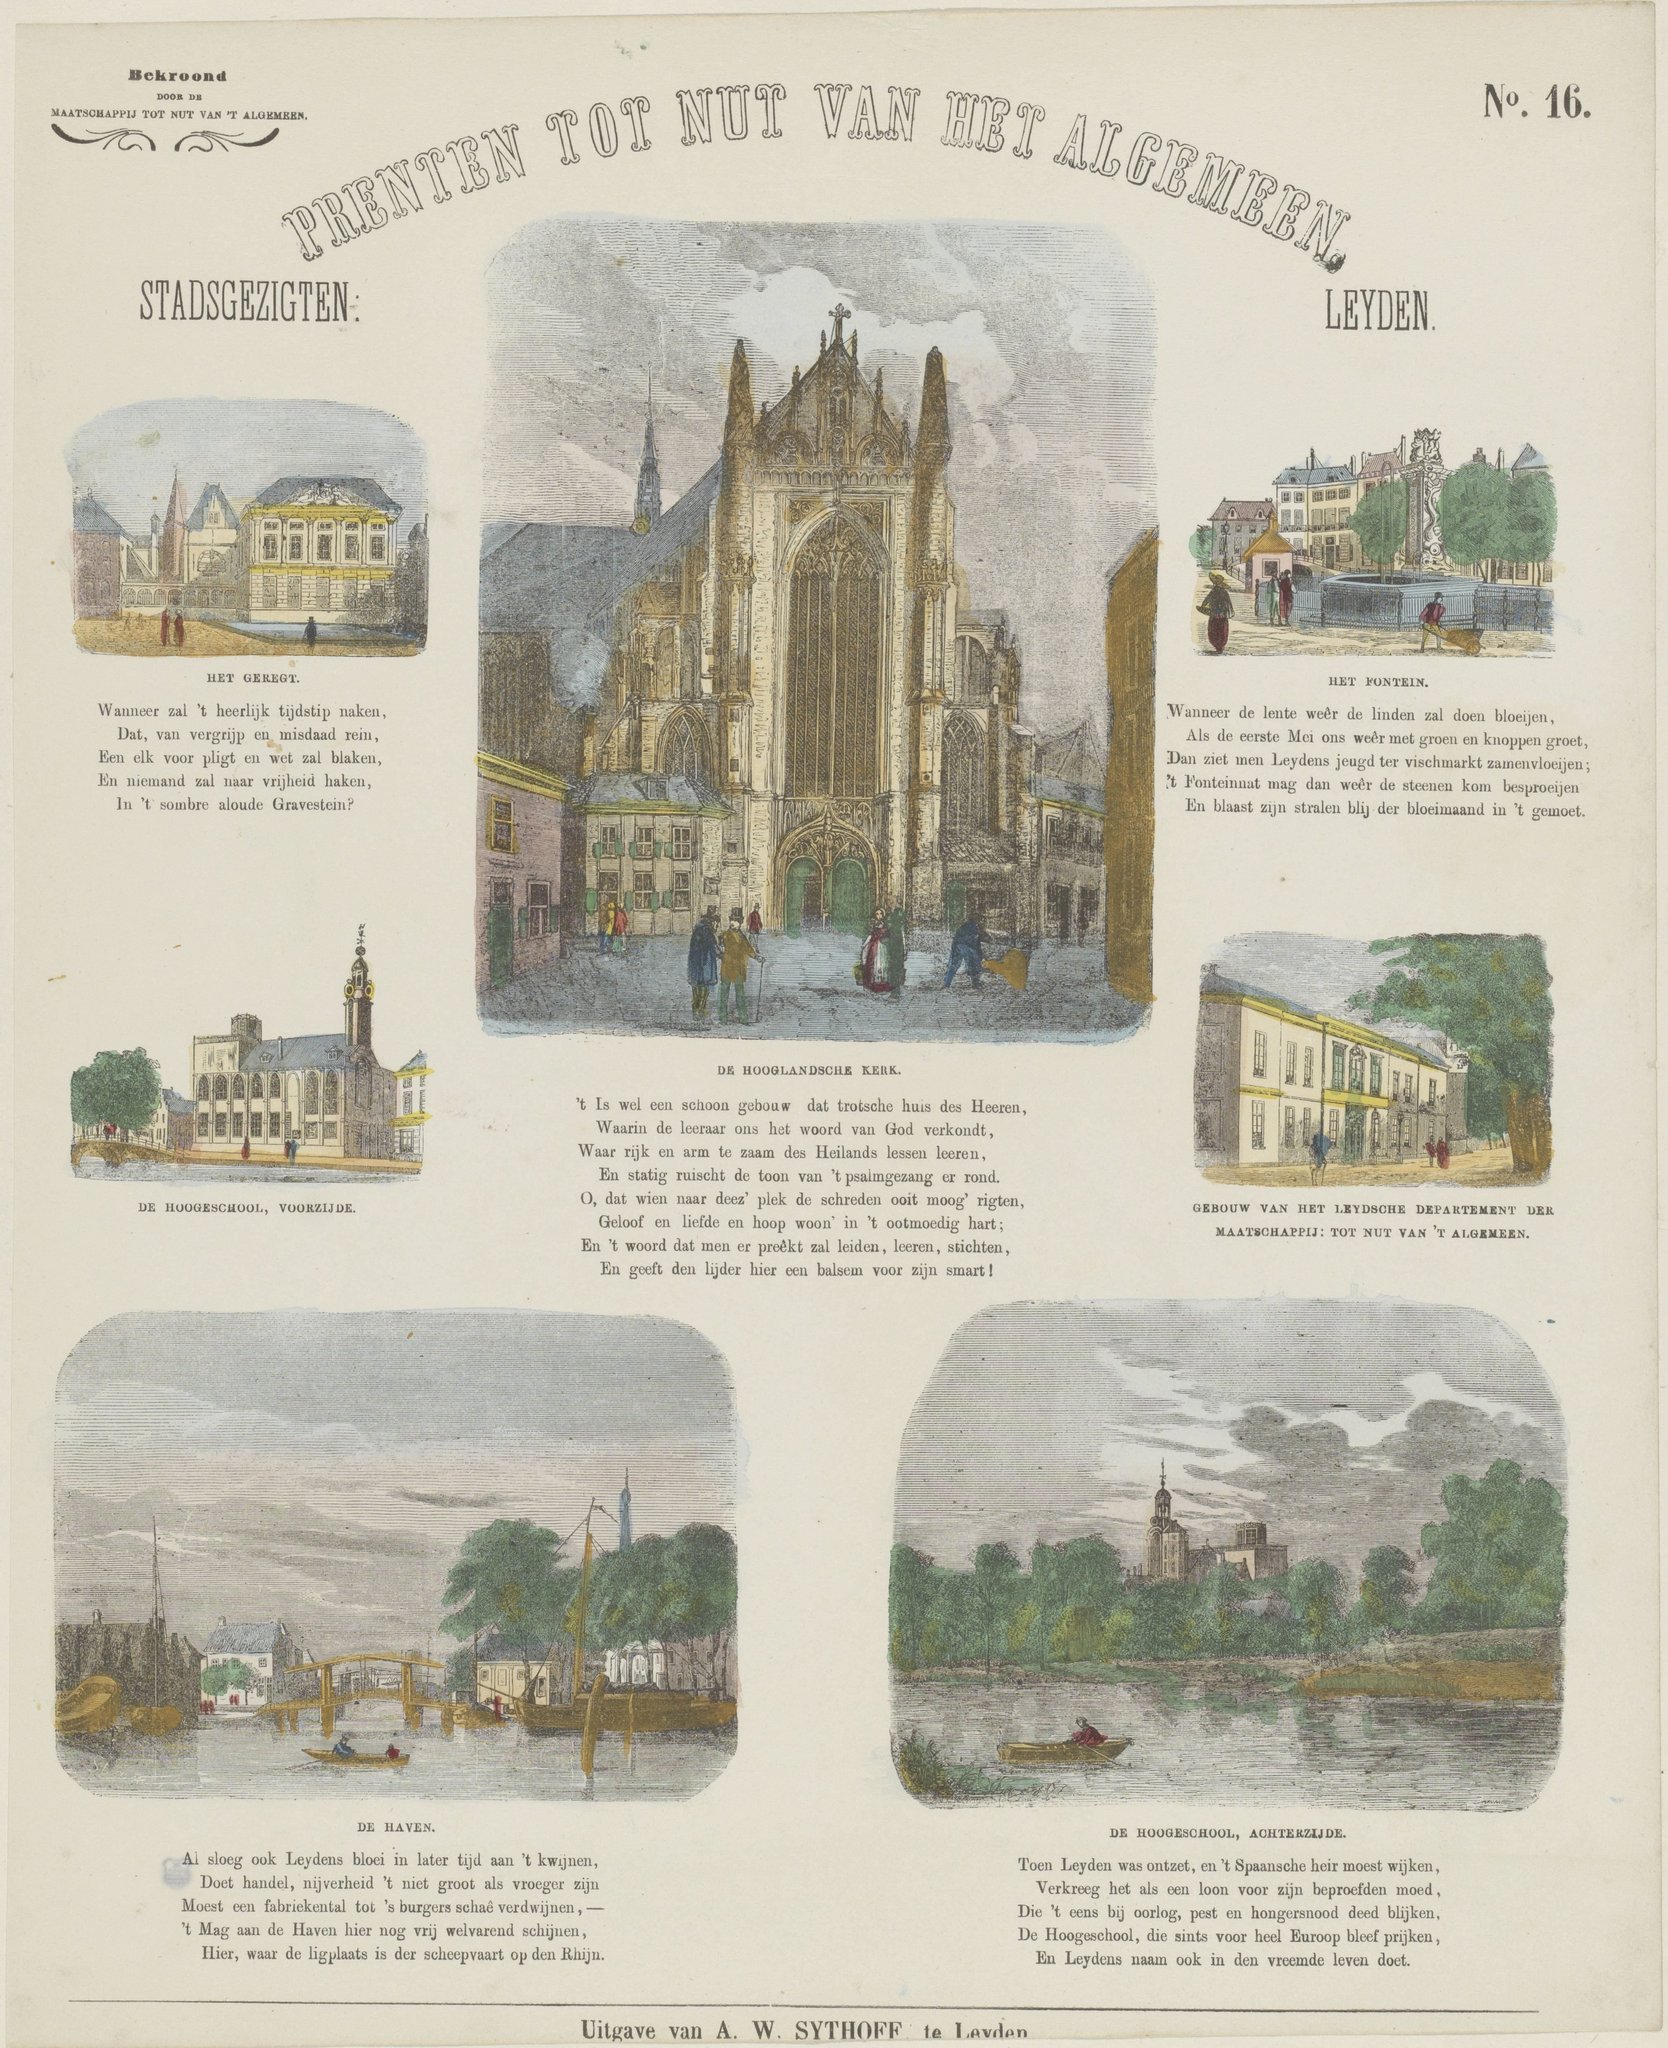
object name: popular print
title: Stadsgezigten: Leyden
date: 1861-1929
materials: paper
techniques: colour, letterpress printing, engraving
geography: europe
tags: harbour, church (exterior), university building, college, ornamental fountain (in village), leiden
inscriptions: collector's mark: Lugt 2760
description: Blad met 7 verschillende gezichten op Leiden. Onder elke afbeelding een onderschrift. Genummerd rechtsboven: No. 16. Linksboven: Bekroond door de Maatschappij tot Nut van 't Algemeen.